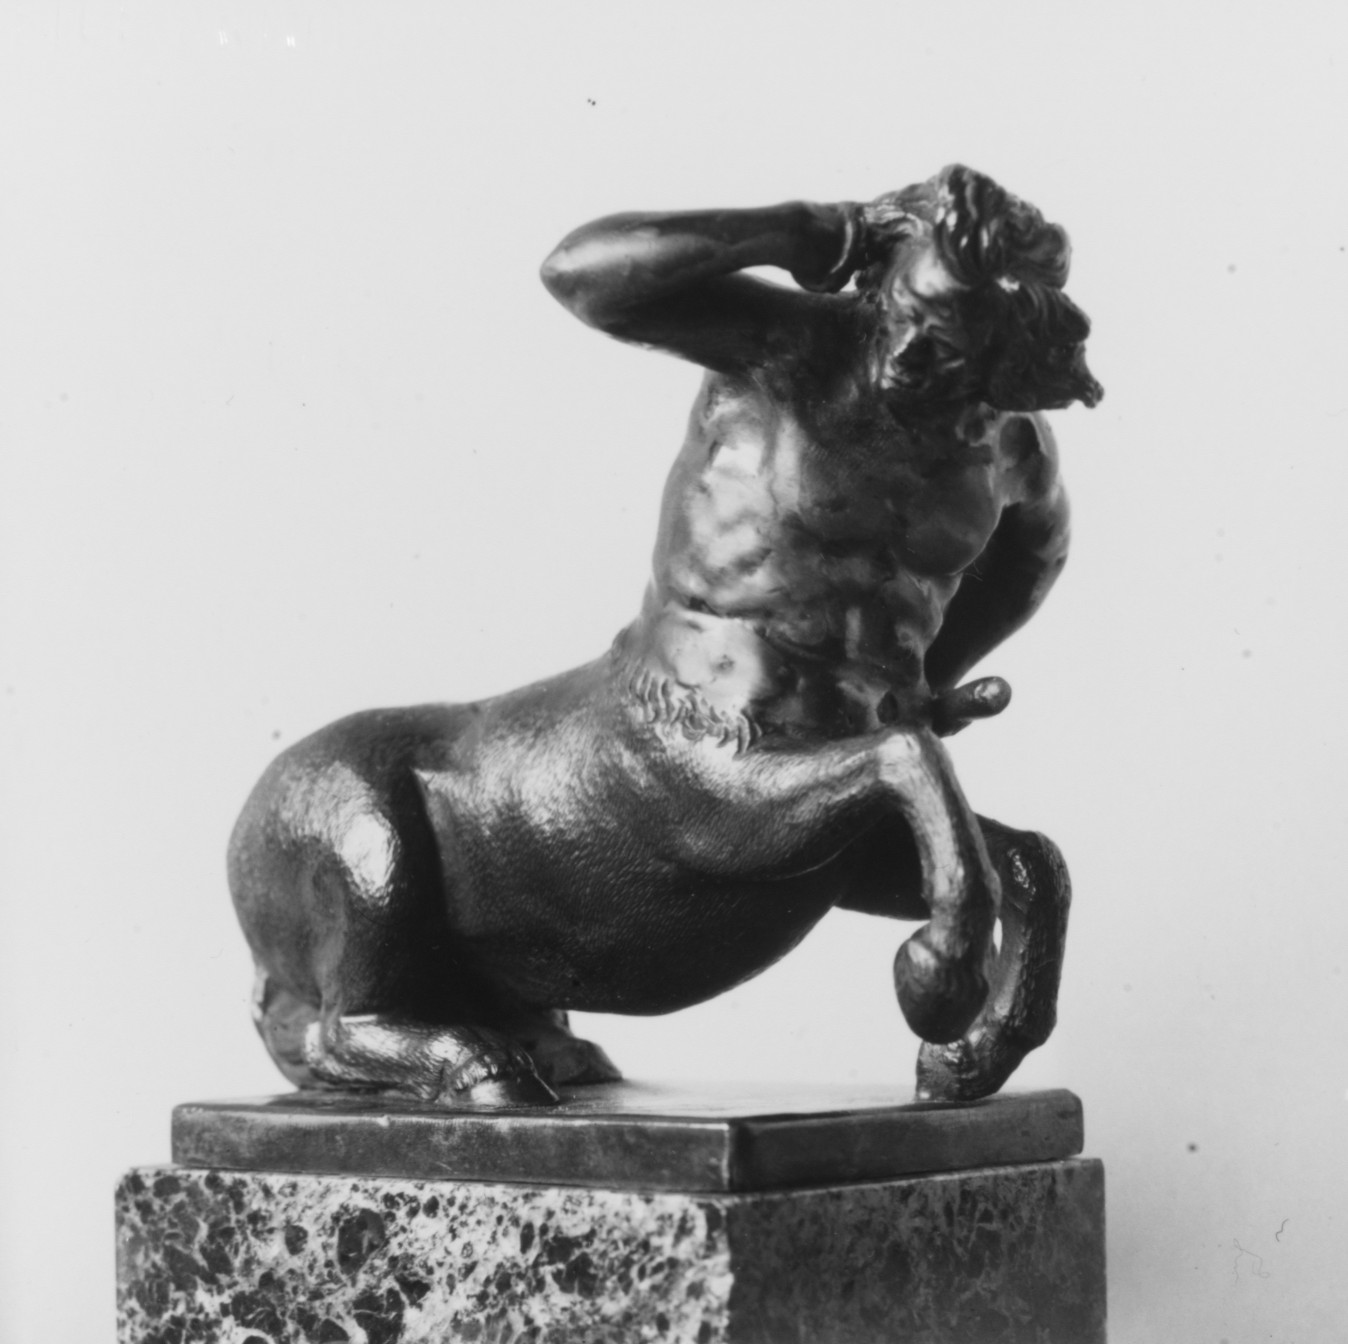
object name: statuette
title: Centaur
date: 1601-1700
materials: bronze, marble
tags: centaurs